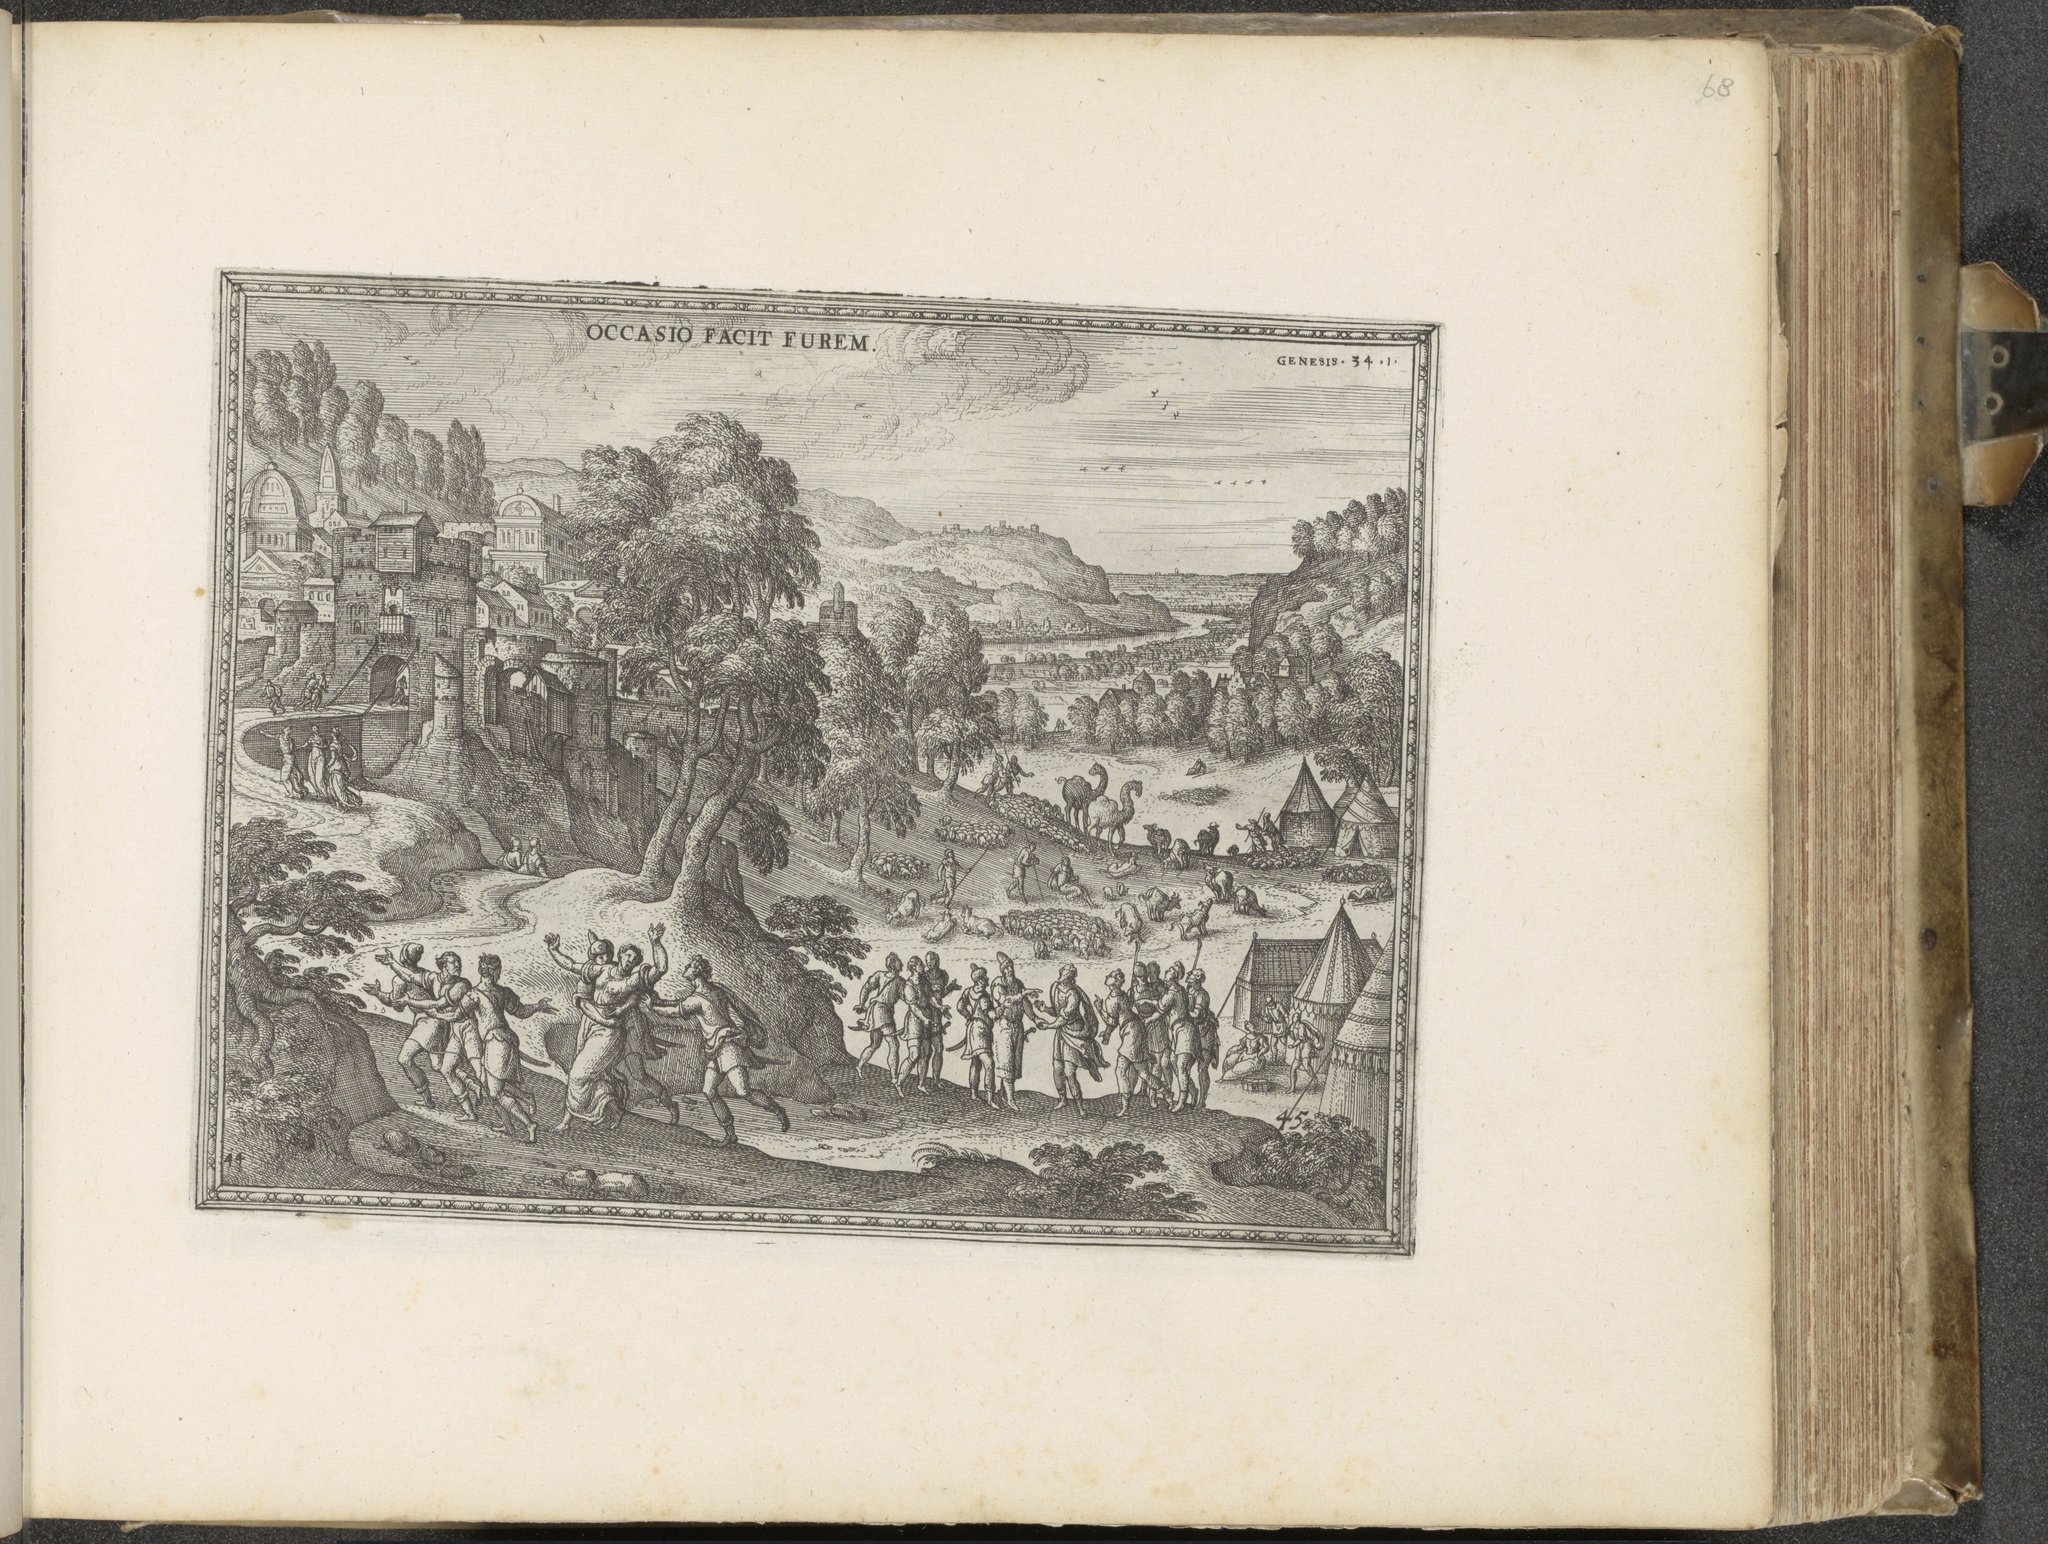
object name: album leaf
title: Den Grooten Emblemata Sacra, bestaande in meer dan vier hondert bybelsche figuren, zoo des Ouden als des Nieuwen Testaments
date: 1582-1593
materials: paper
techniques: etching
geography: amsterdam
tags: city-view, and landscape with man-made constructions, hamor and shechem come to jacob, whose sons have just come in from the fields, to ask for dinah in marriage; the sons agree on condition that the shechemites will be circumcised, old testament, the rape of dinah by shechem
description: Heuvelachtig landschap. Links wordt Dina, de dochter van Jakob, overweldigd en meegenomen door Sichem. Rechts vragen Sichem en Chamor, zijn vader, aan Jakob en zijn zonen om Dina's hand (Gen. 34:1). De prent maakt deel uit van een album.